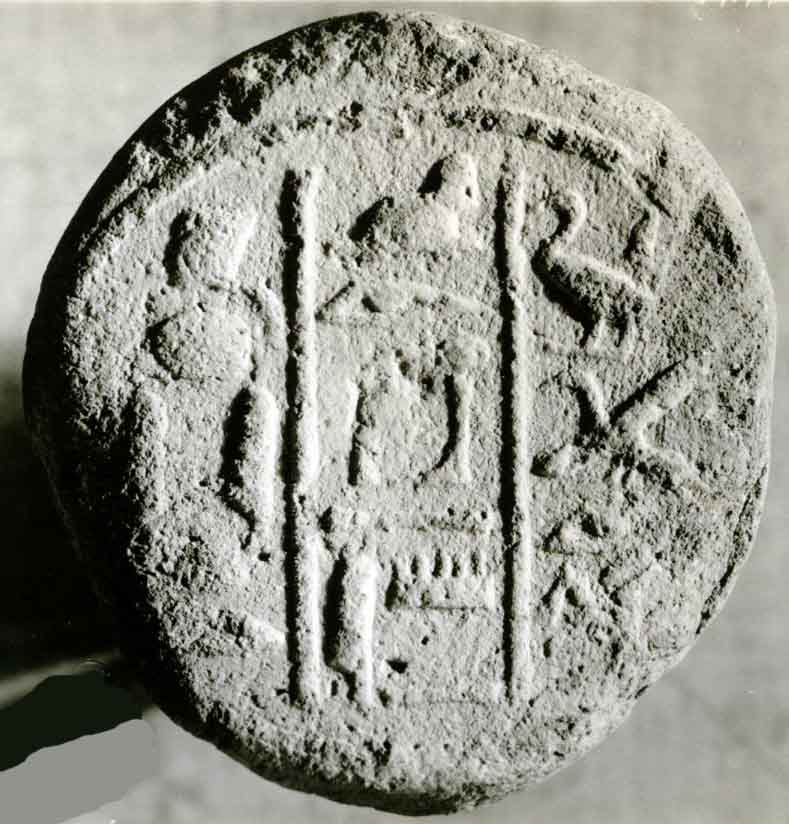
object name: cone, circular impression, sapair, wab priest of amun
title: Funerary Cone of Sapair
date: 1550-1295 BCE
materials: pottery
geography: egypt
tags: hieroglyphs